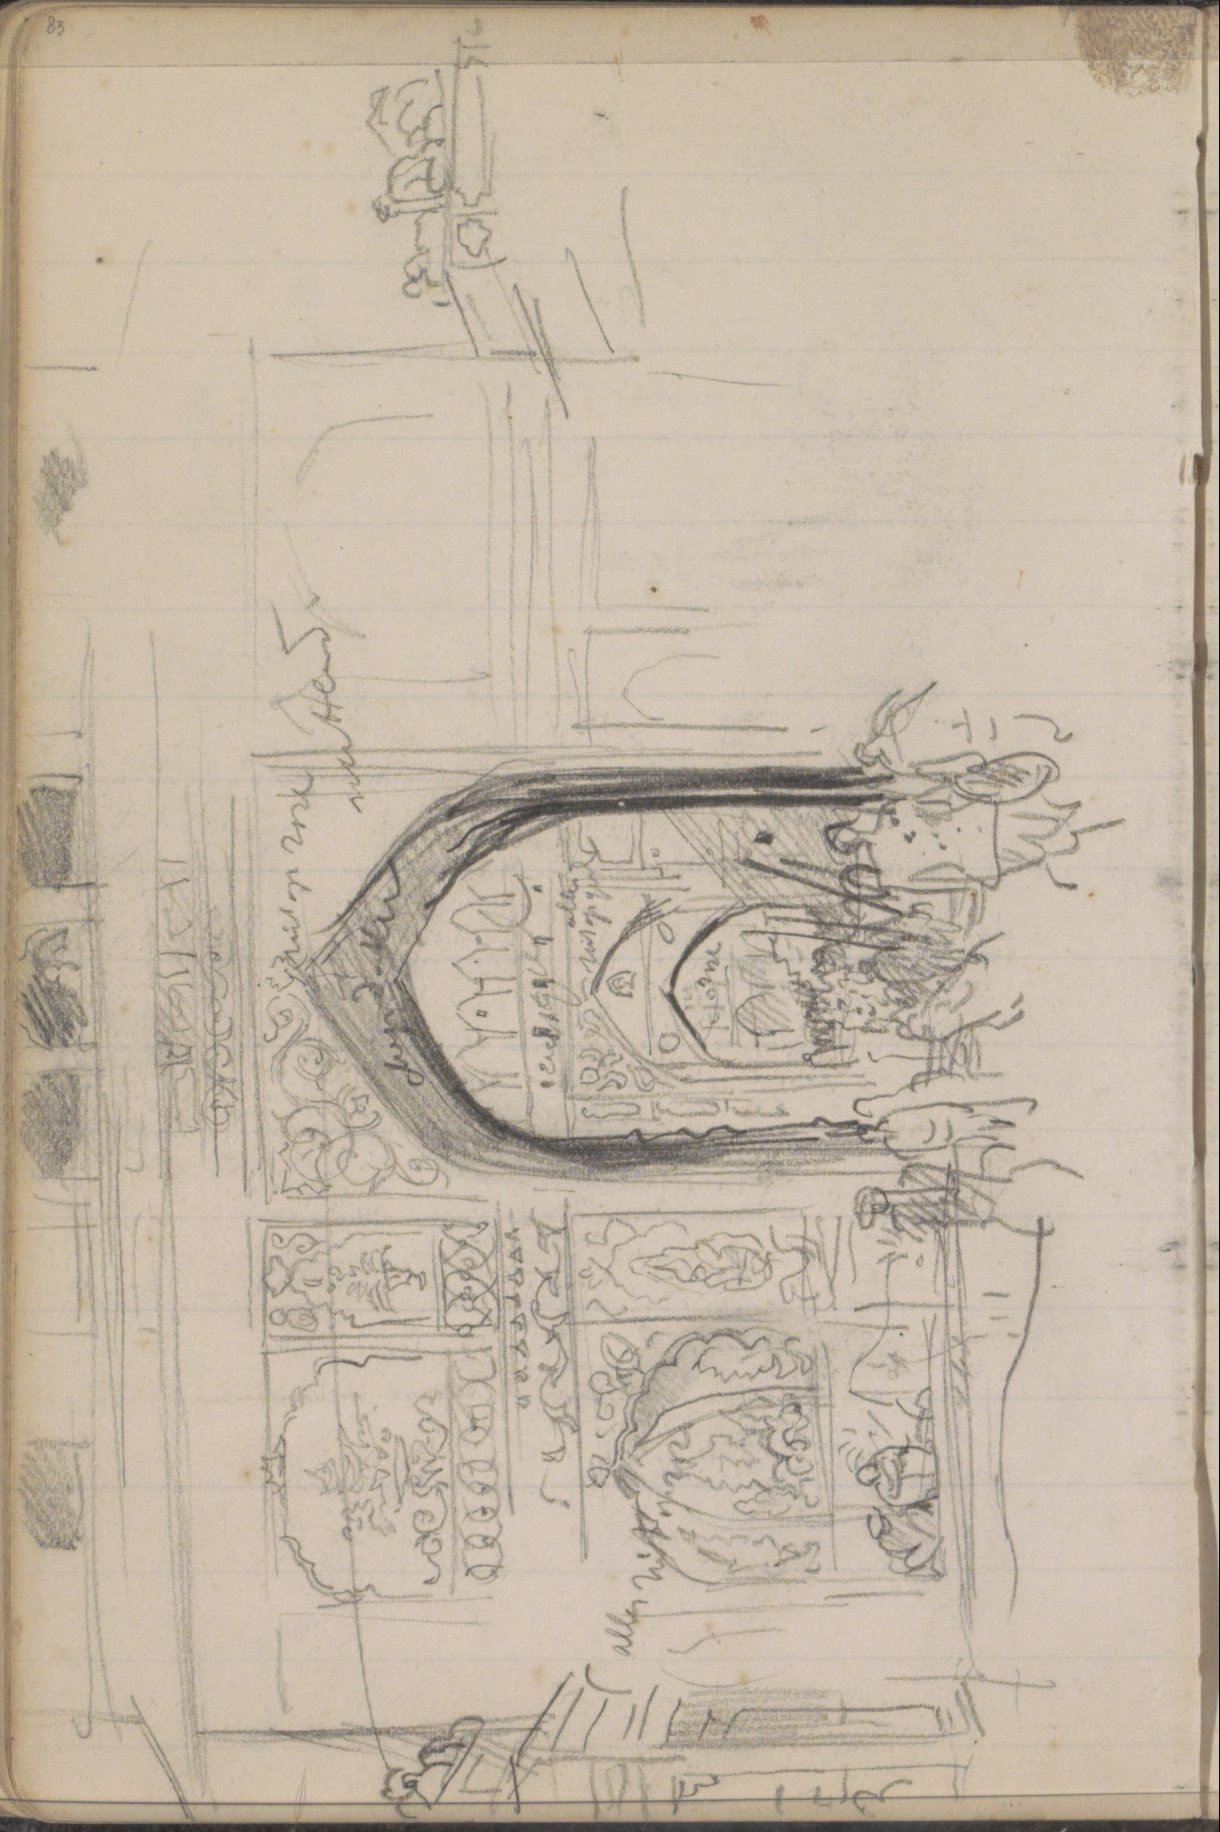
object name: sketchbook leaf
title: Indiërs bij de poort van een binnenplaats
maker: marius bauer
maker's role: draughtsman, print maker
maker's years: 1867-1932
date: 1897-1898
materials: pencil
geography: india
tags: arch, archivolt ~ architecture, courtyard, asiatic races and peoples: indians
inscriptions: kleurnotitie, handgeschreven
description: Pagina 83 uit een schetsboek met 84 bladen.